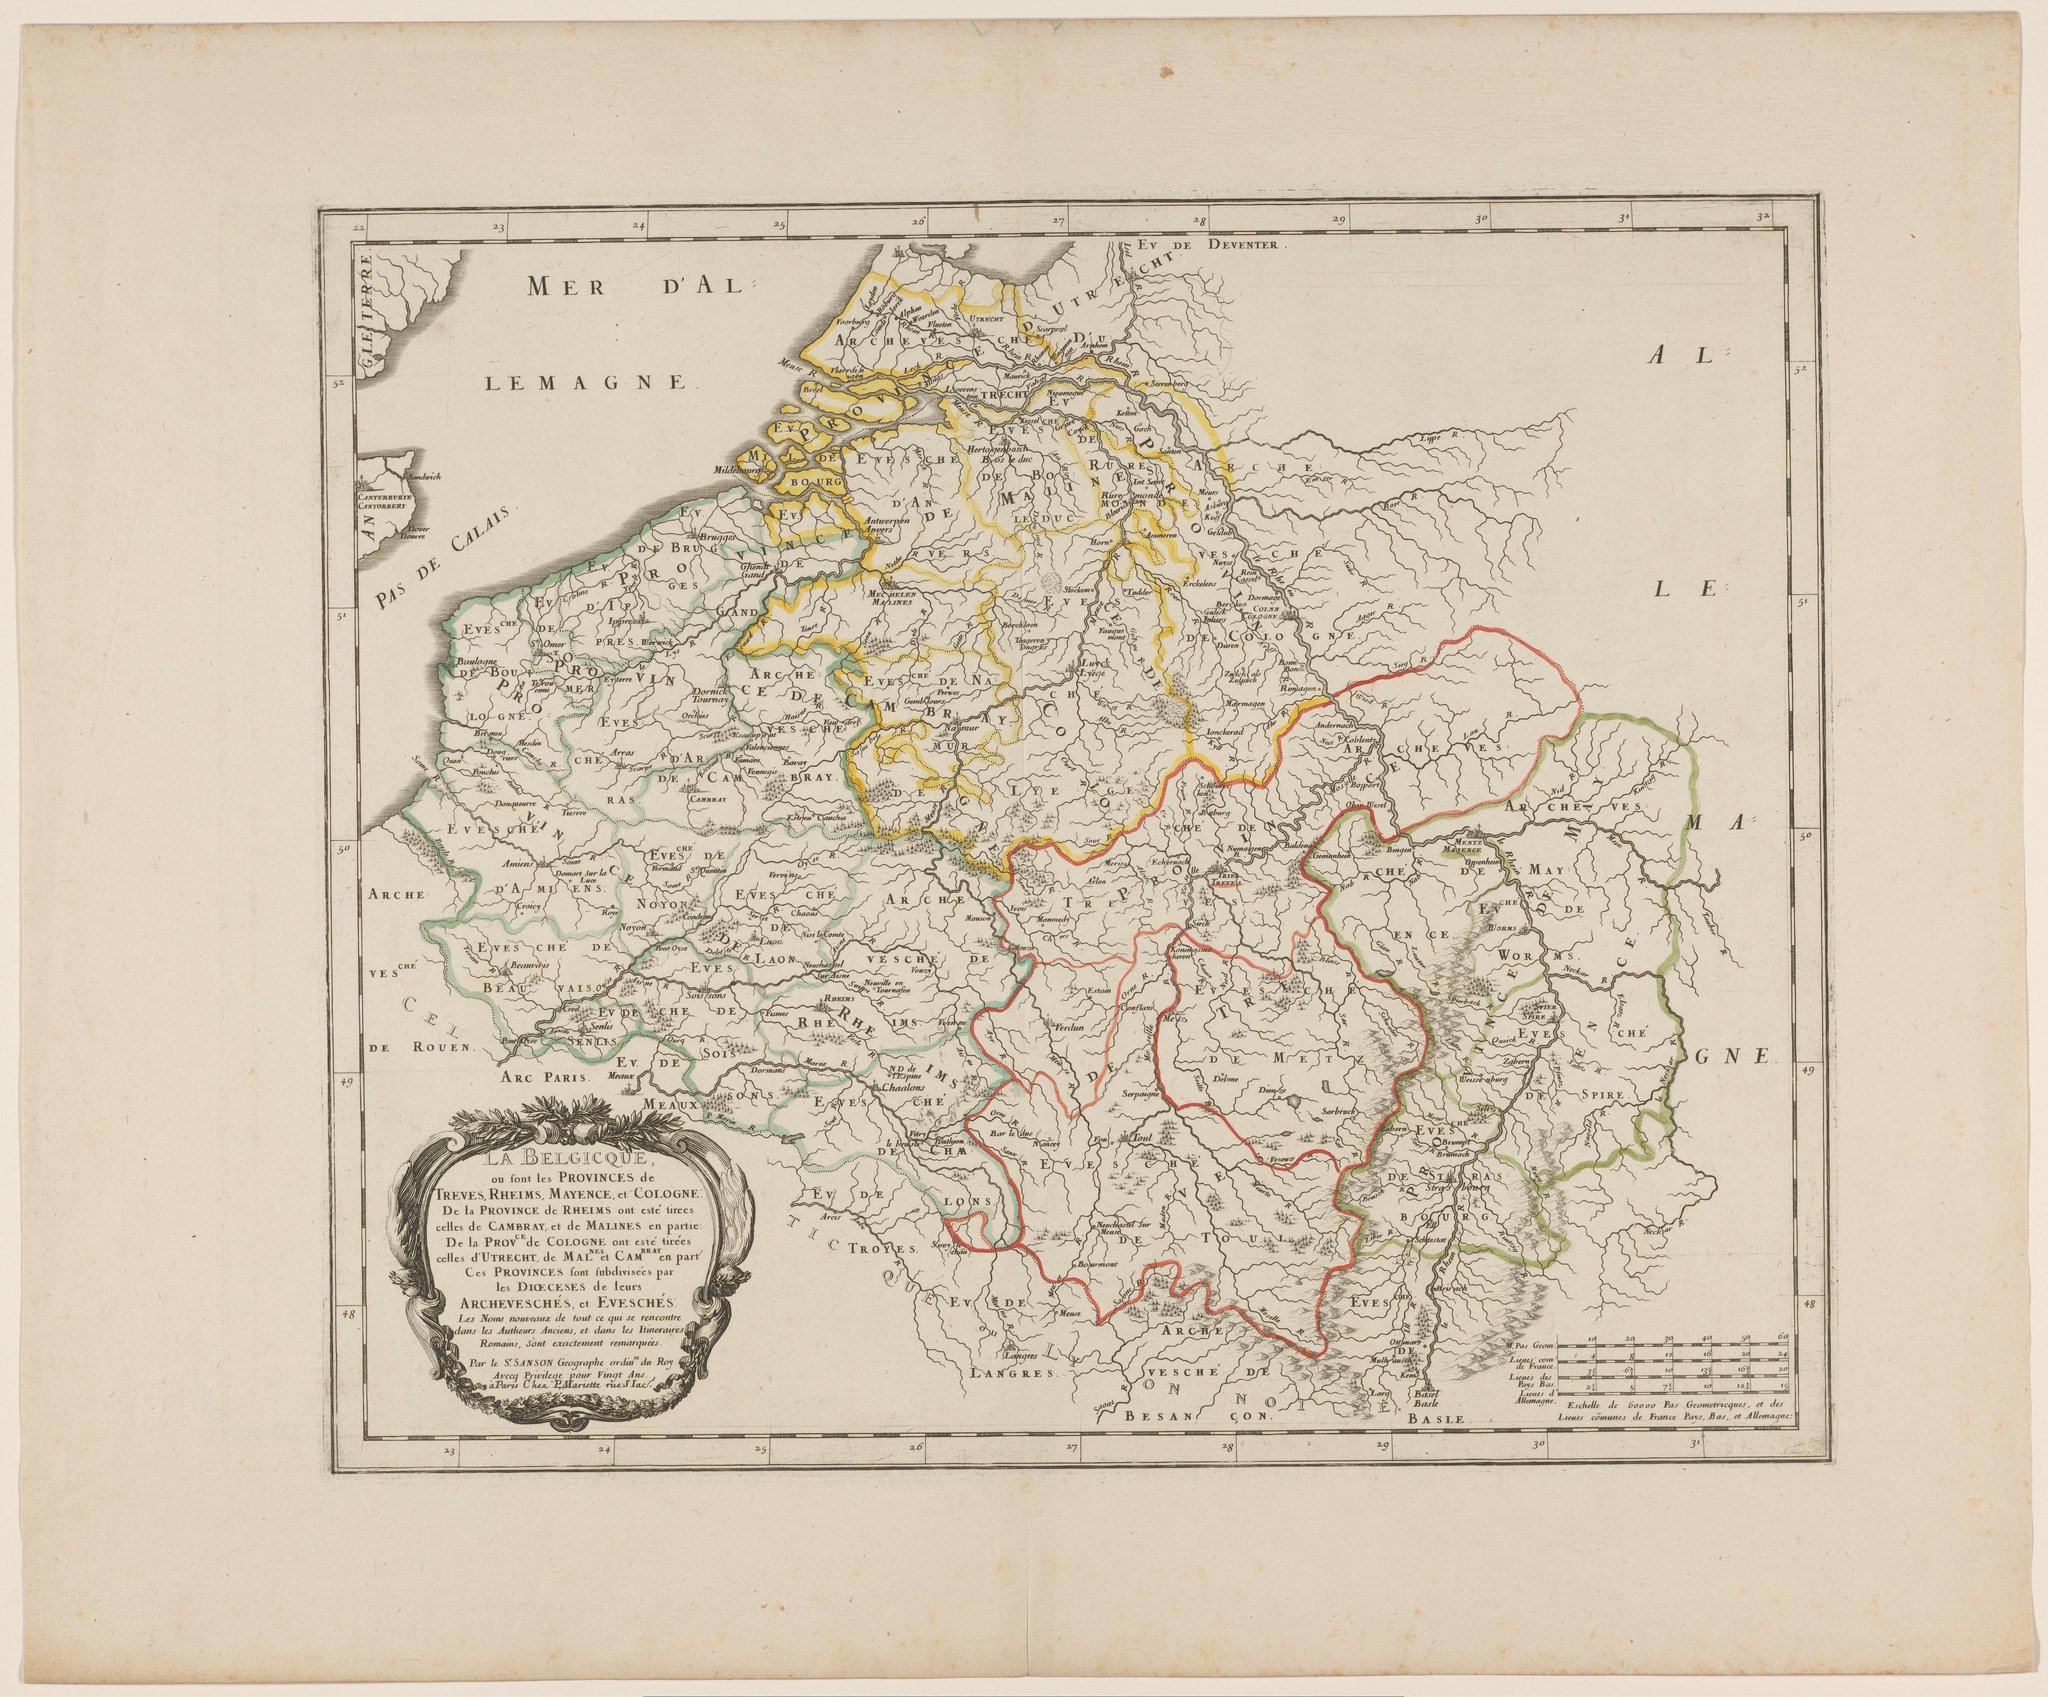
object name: print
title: La Belgique, ou sont les provinces de Treves, Rheims, Mayence (...)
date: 1647-1674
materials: paper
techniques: engraving, hand coloring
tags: maps of separate countries or regions, southern netherlands, belgium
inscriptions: collector's mark: Lugt 2228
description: Kaart van de Zuidelijke Nederlanden. Linksonder de titelcartouche. Rechtsonder vier schaalstokken: 60 M. Pas Geom. / 24 Lieues com de France / 20 Lieues des Pays Bas en een andere. De kaart is voorzien van een gradenverdeling langs de randen.